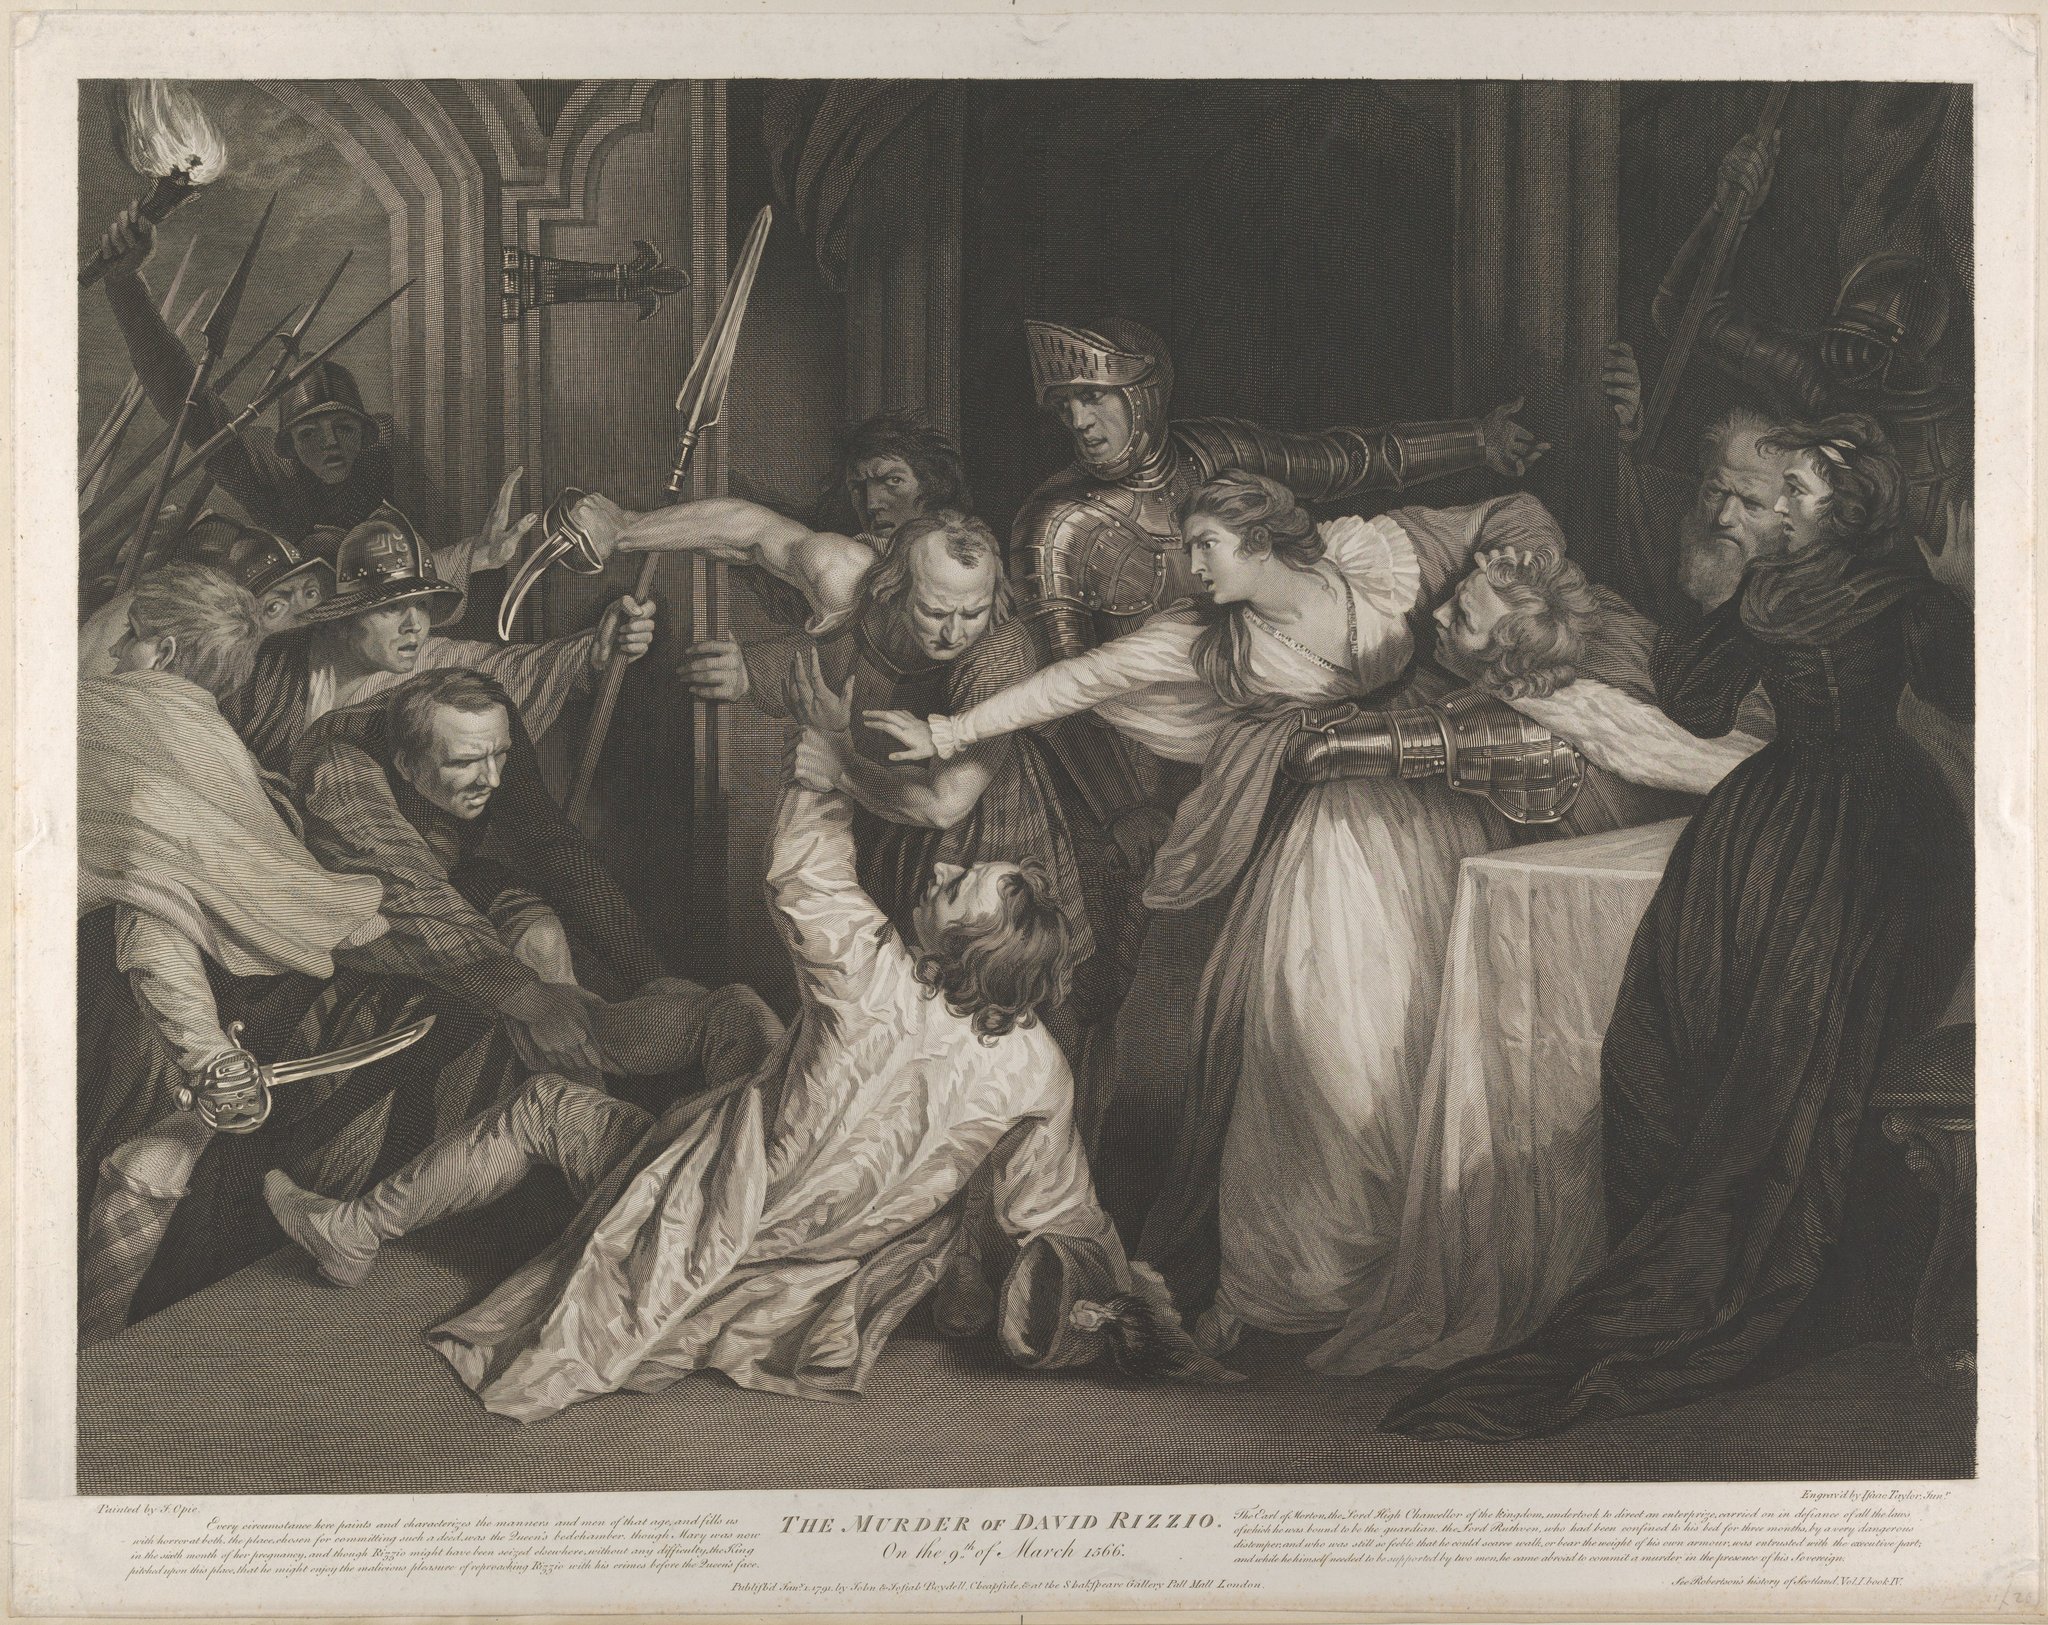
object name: print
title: Mary, Queen of Scots witnessing the murder of David Rizzio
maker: isaac taylor, jr.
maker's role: engraver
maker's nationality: british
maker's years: 1759-1829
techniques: engraving, etching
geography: england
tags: queens,men,mary queen of scots